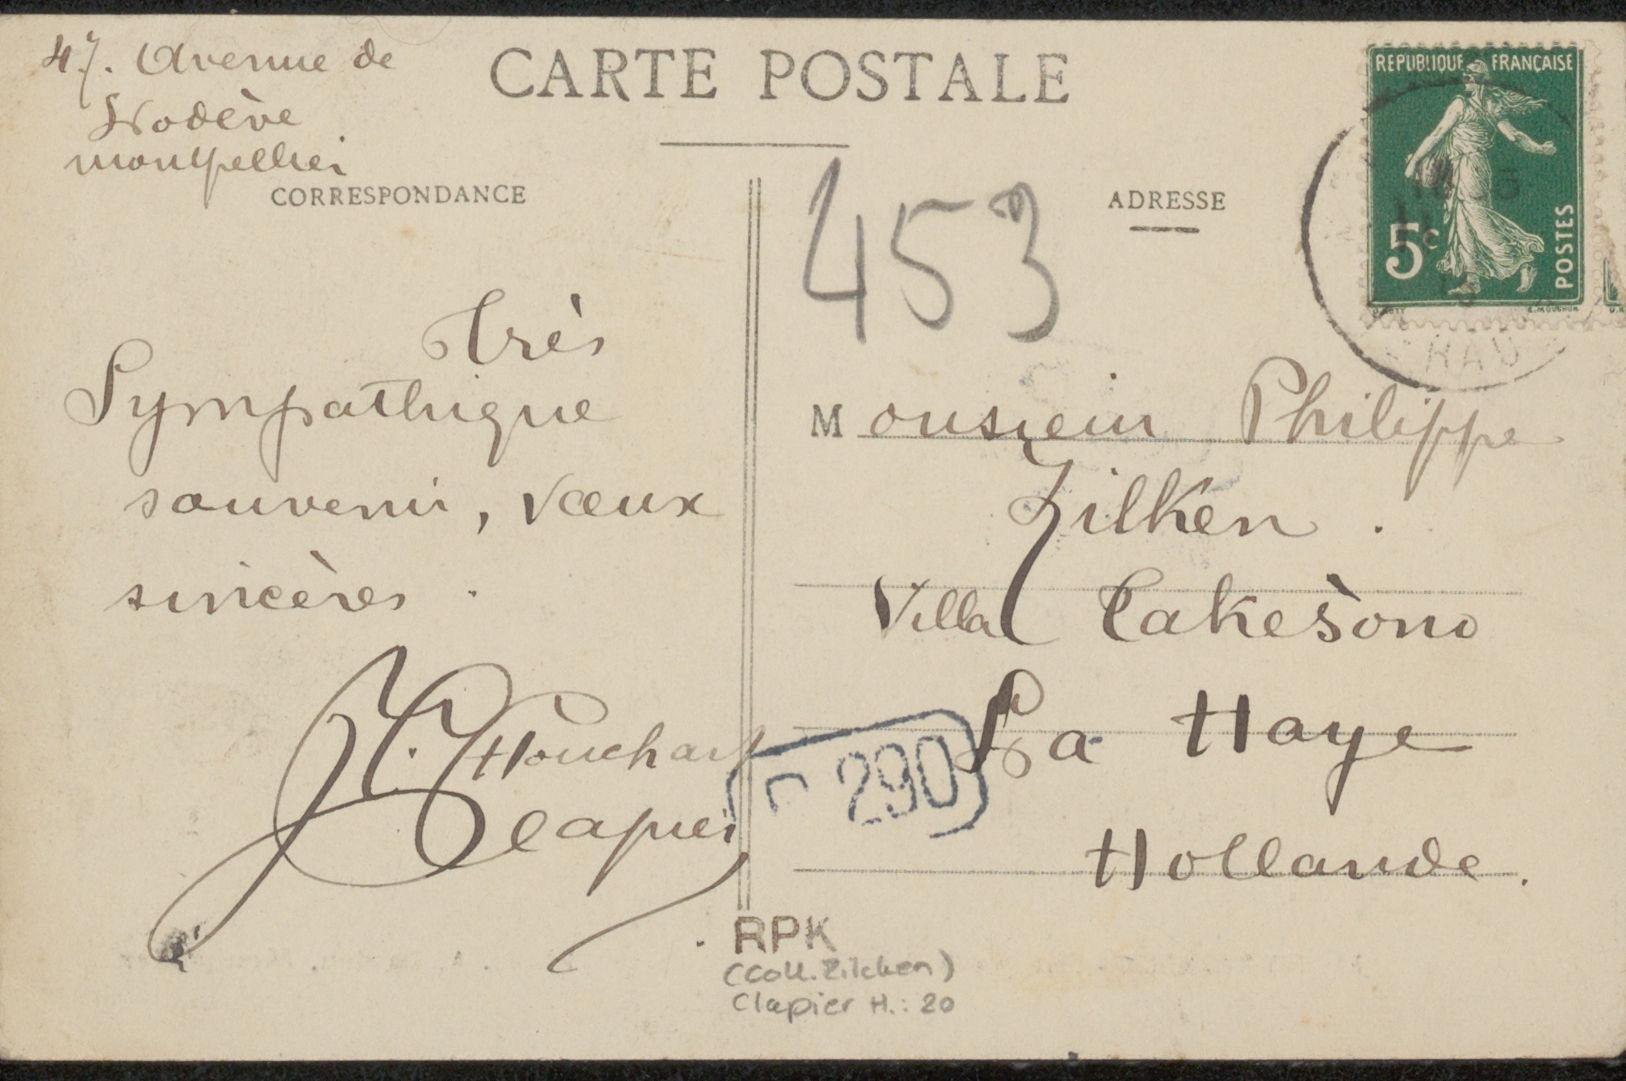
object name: ansichtkaart, prentbriefkaart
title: Prentbriefkaart aan Philip Zilcken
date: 1909-1930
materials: cardboard, ink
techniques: pen, printing, writing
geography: montpellier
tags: the hague, painter, draughtsman, philip zilcken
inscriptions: collector's mark: ‘RPK’